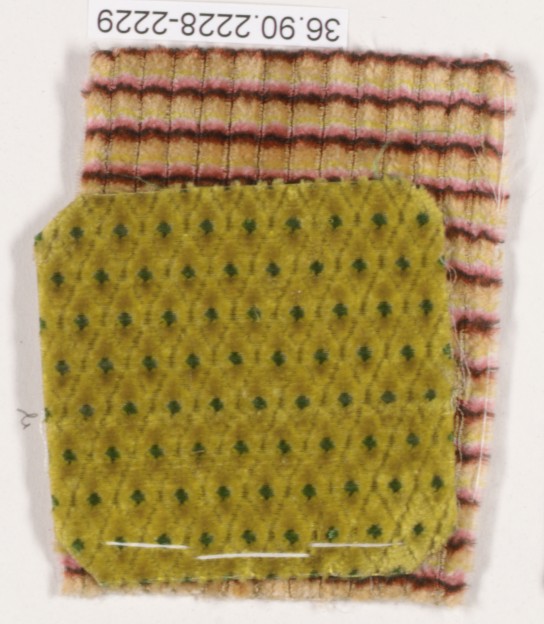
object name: piece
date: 1801-1900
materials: silk